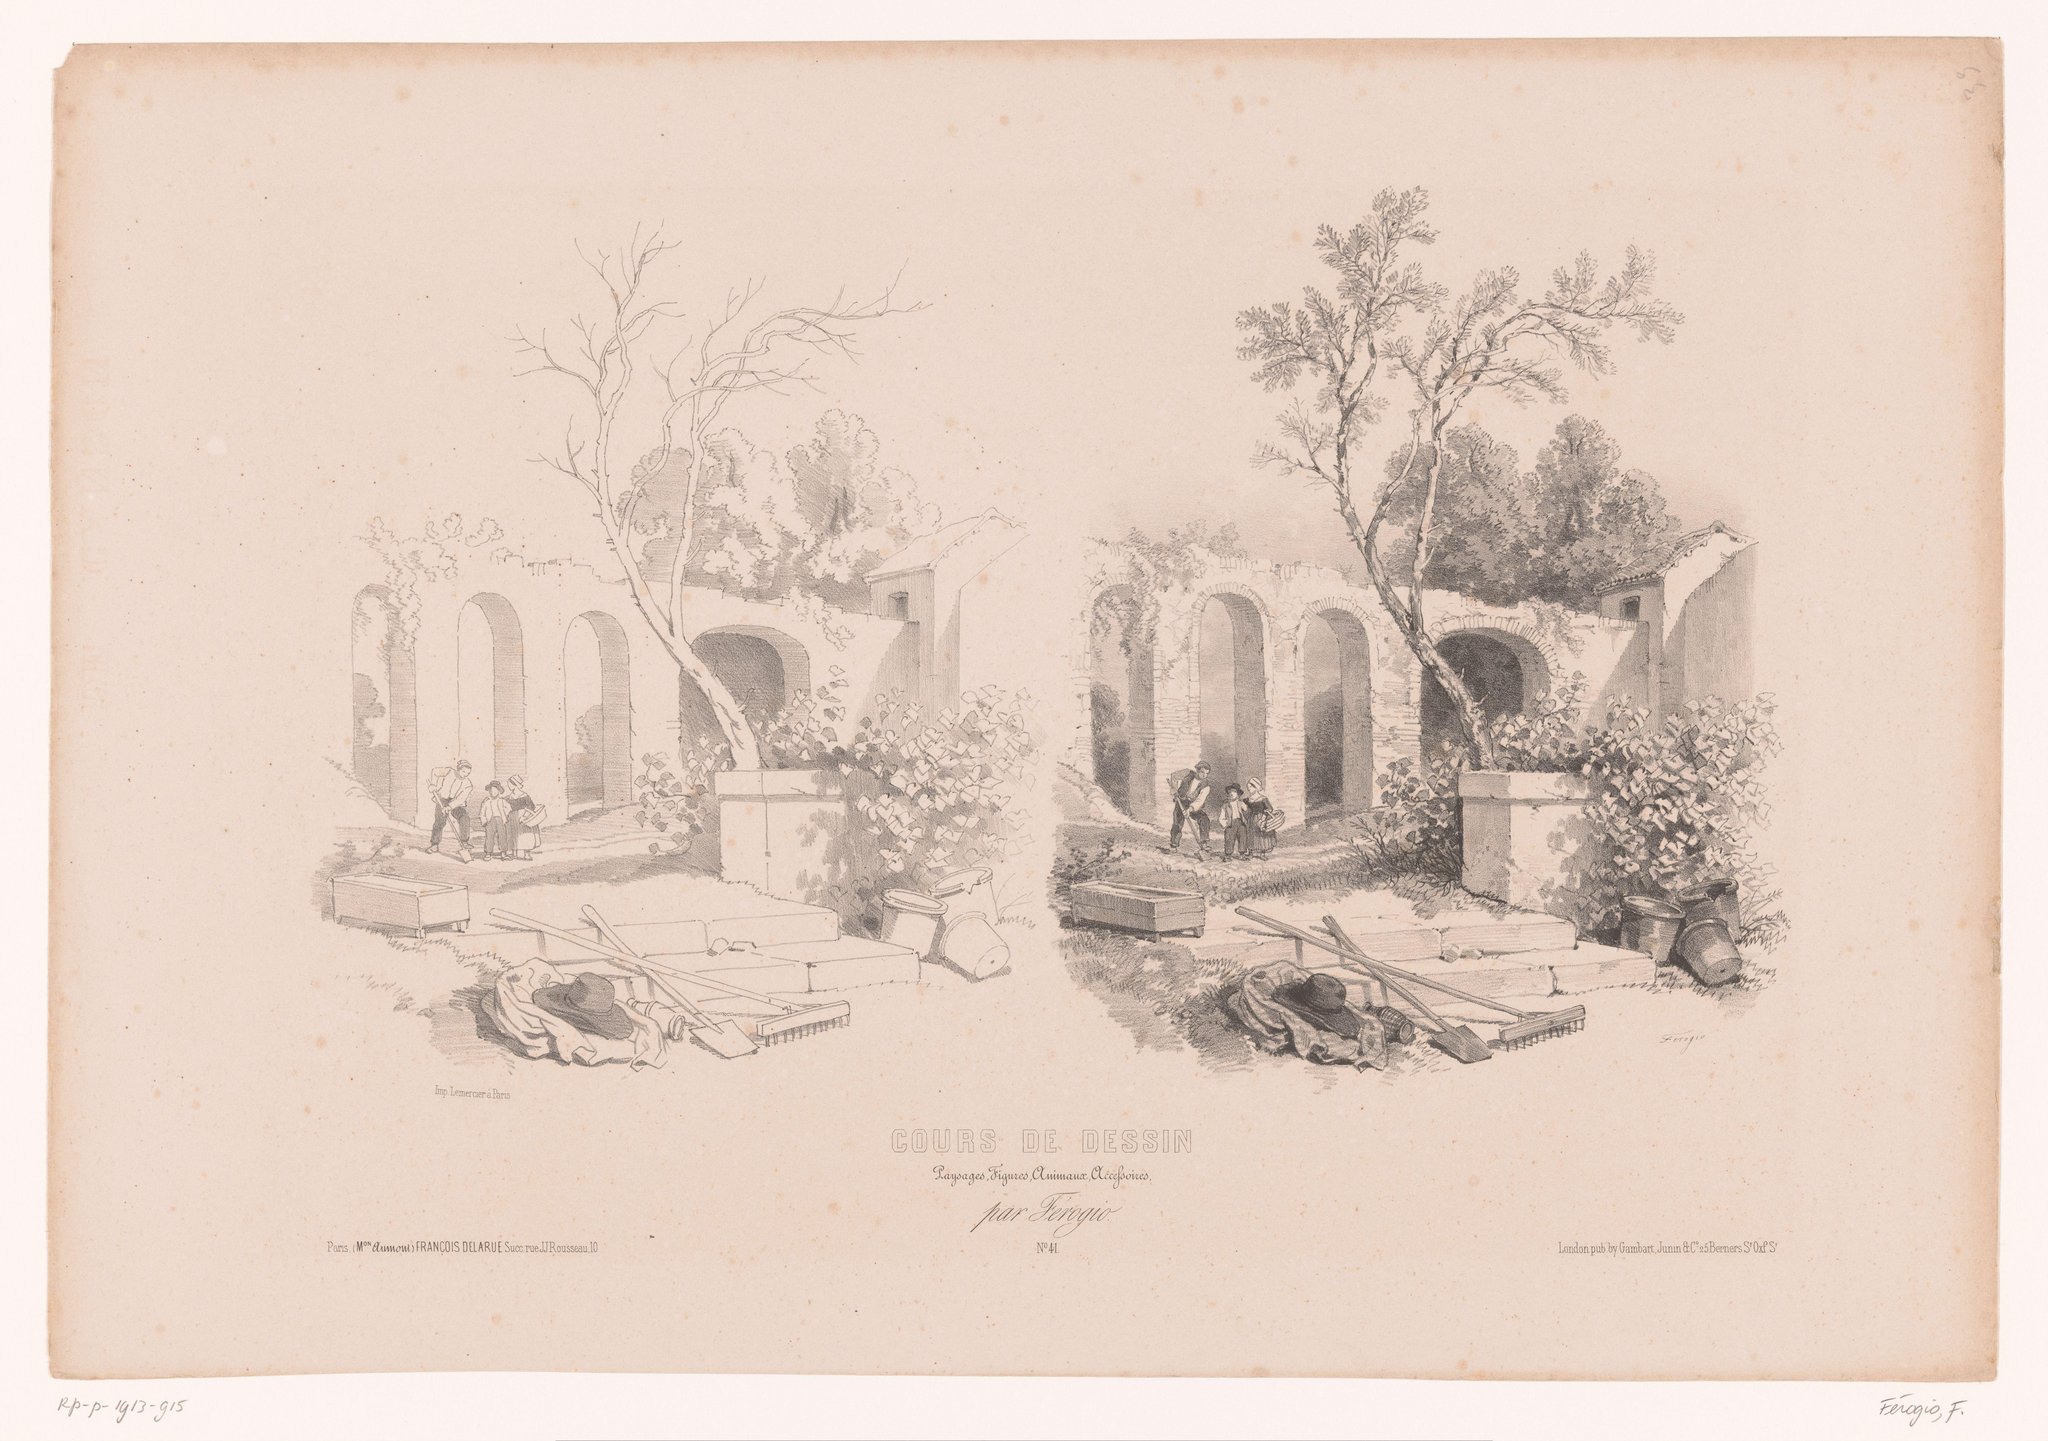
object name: print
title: Tekencursus met studies van landschappen, dieren en details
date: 1845-1846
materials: paper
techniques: lithograph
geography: paris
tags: farmers, landscape with ruins, arcade ~ architecture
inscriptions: collector's mark: Lugt 2228a